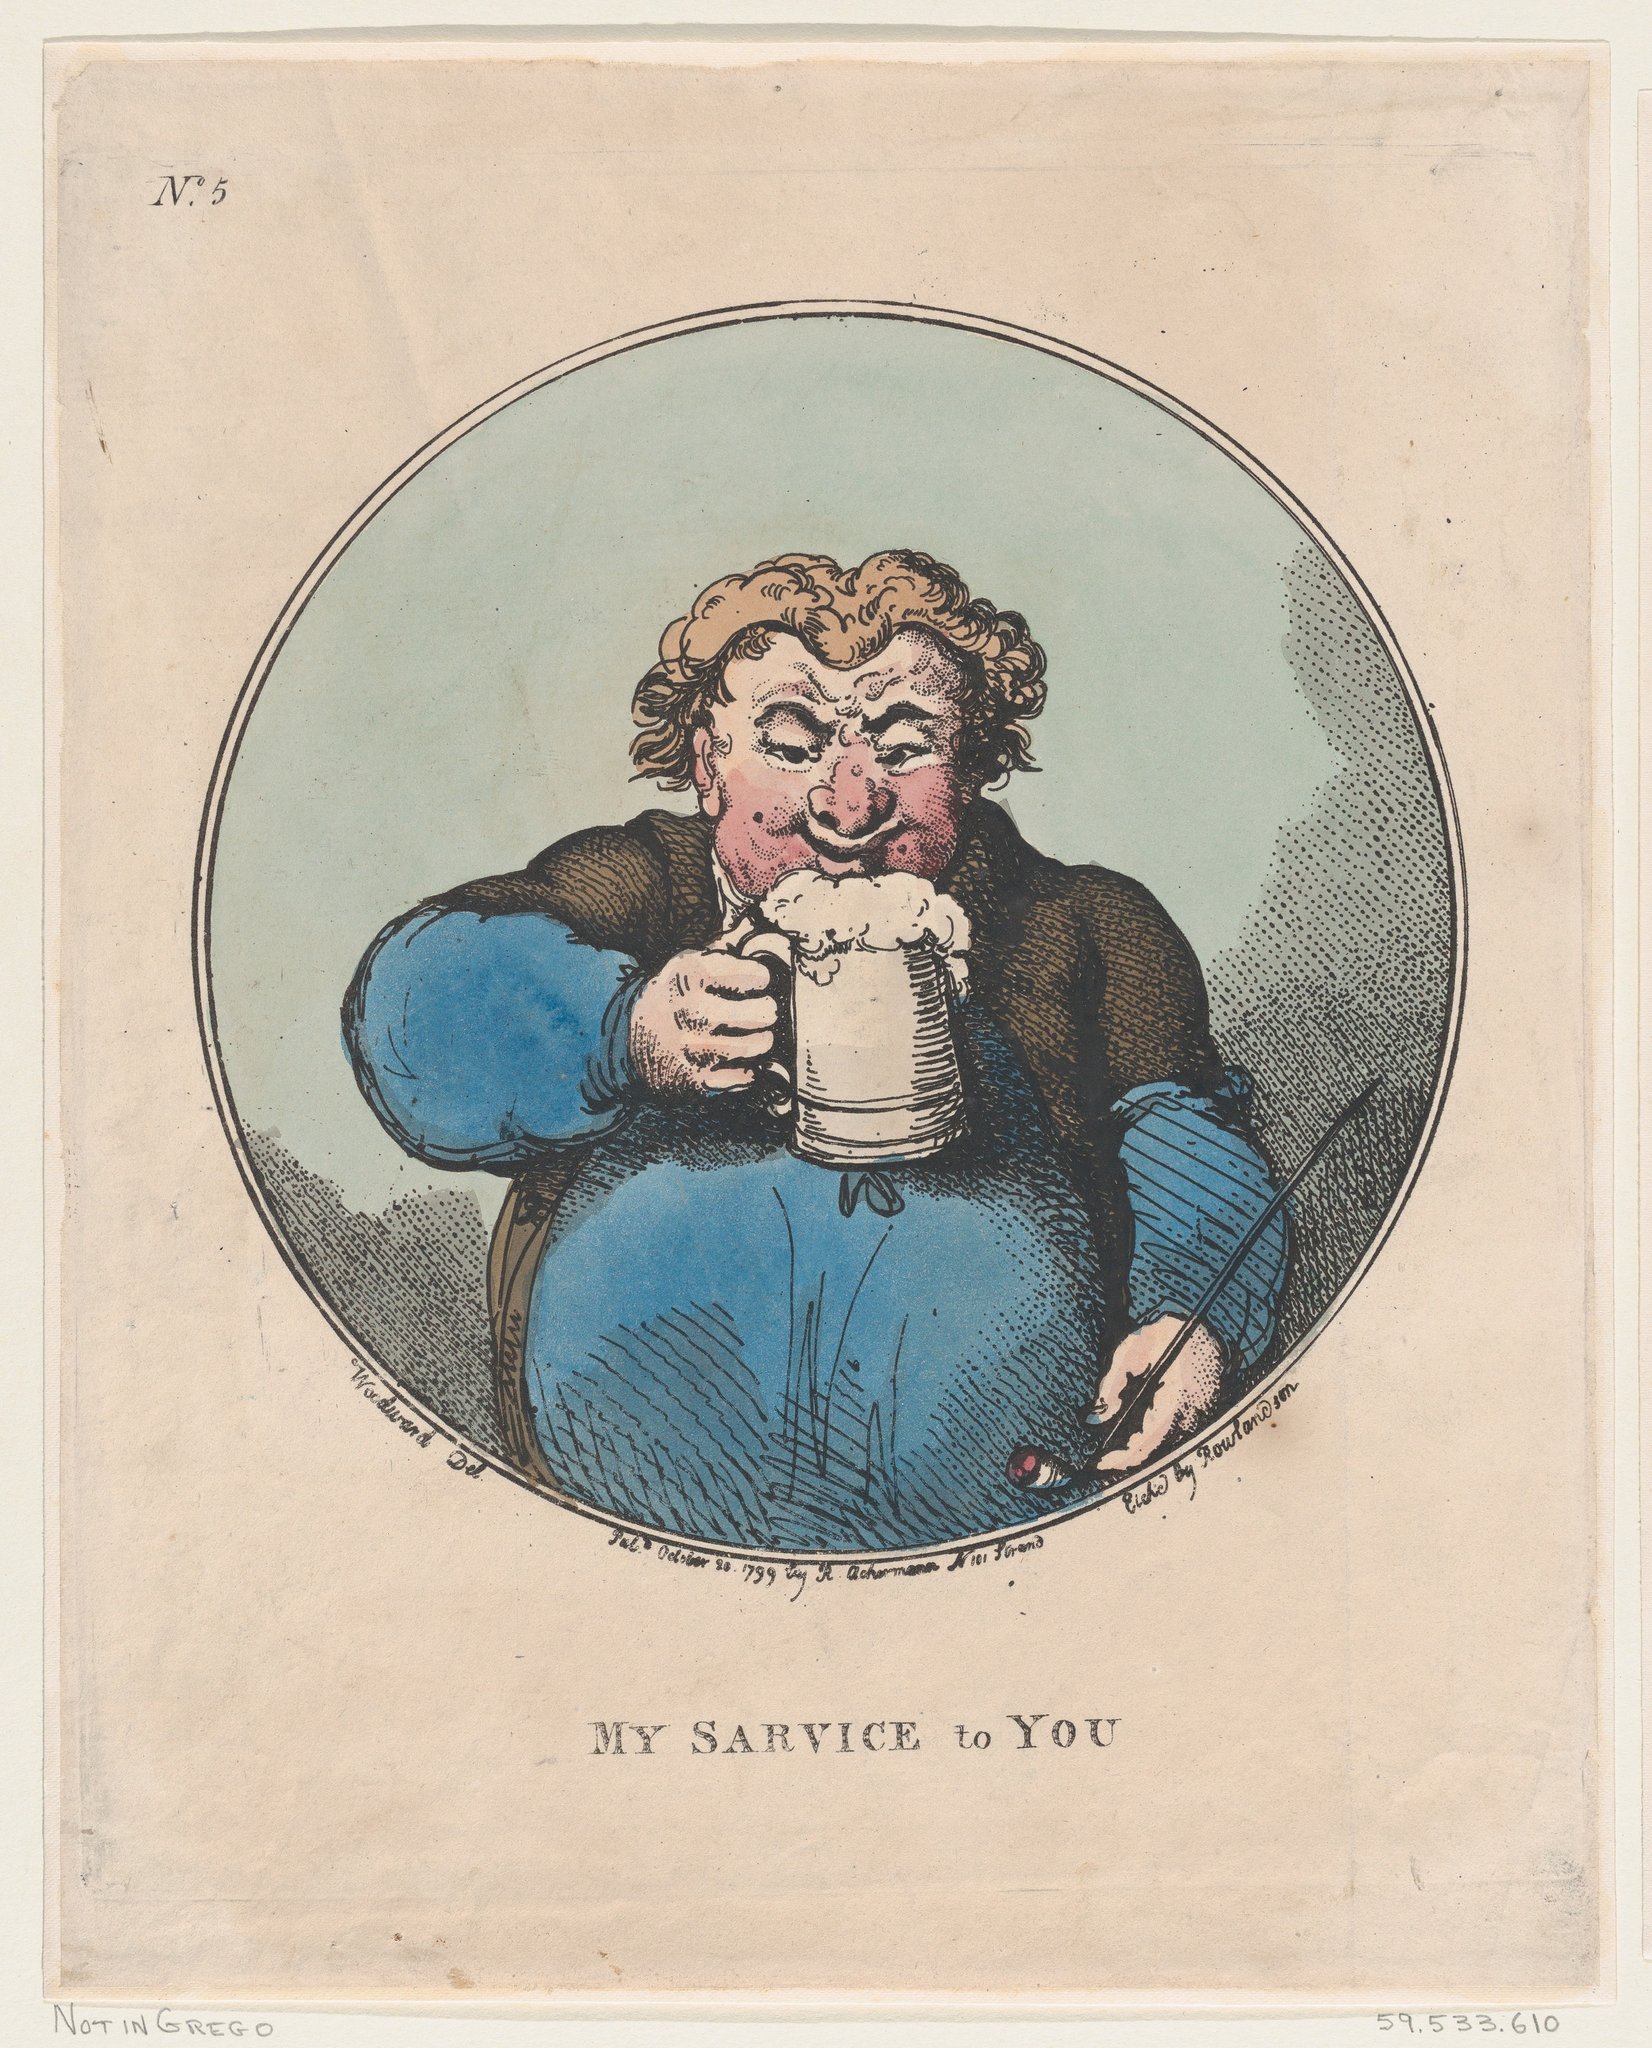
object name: print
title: My Service To You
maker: thomas rowlandson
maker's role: artist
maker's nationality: british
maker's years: 1757-1827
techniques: etching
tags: men